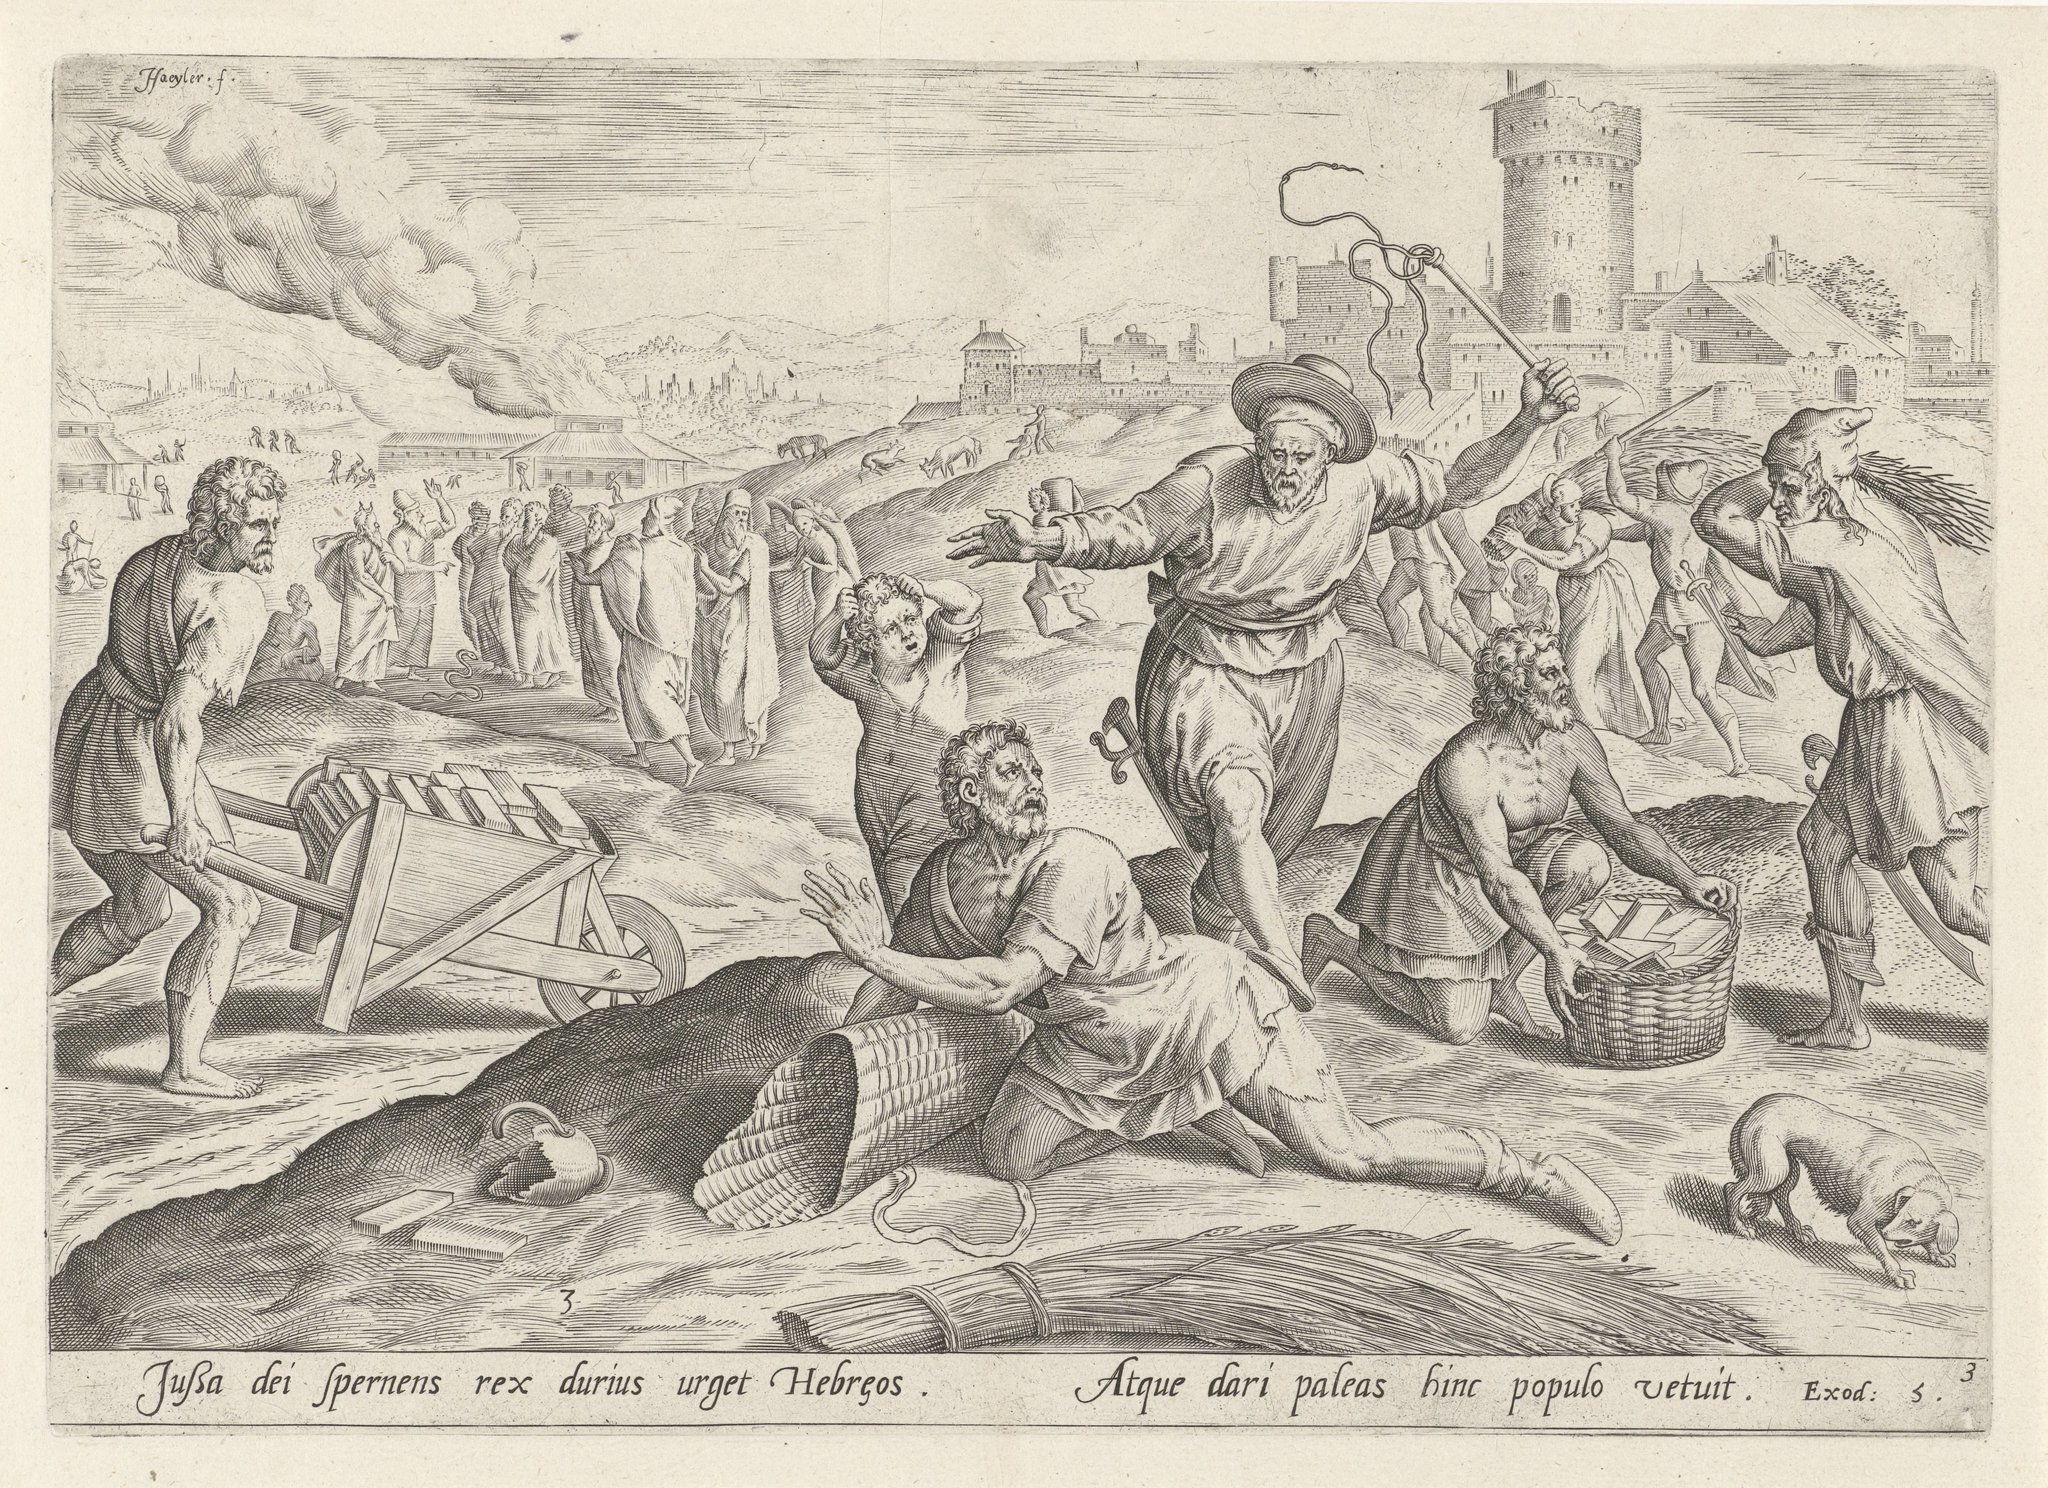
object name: print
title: Geschiedenis van Mozes voor de Exodus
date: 1579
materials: paper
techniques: engraving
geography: antwerp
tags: moses sees how the israelites are forced to do hard labour, moses beholding one of his countrymen being beaten by an egyptian taskmaster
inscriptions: collector's mark: Lugt 2228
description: Eerste staat gebruikt als boekillustratie voor Thesaurus Sacrarum Historiarum Veteris Testamenti. Antwerpen: Gerard de Jode, 1579. Ook gebruikt als boekillustratie voor Theatrum Biblicum. Amsterdam: C.J. Visscher, 1639.